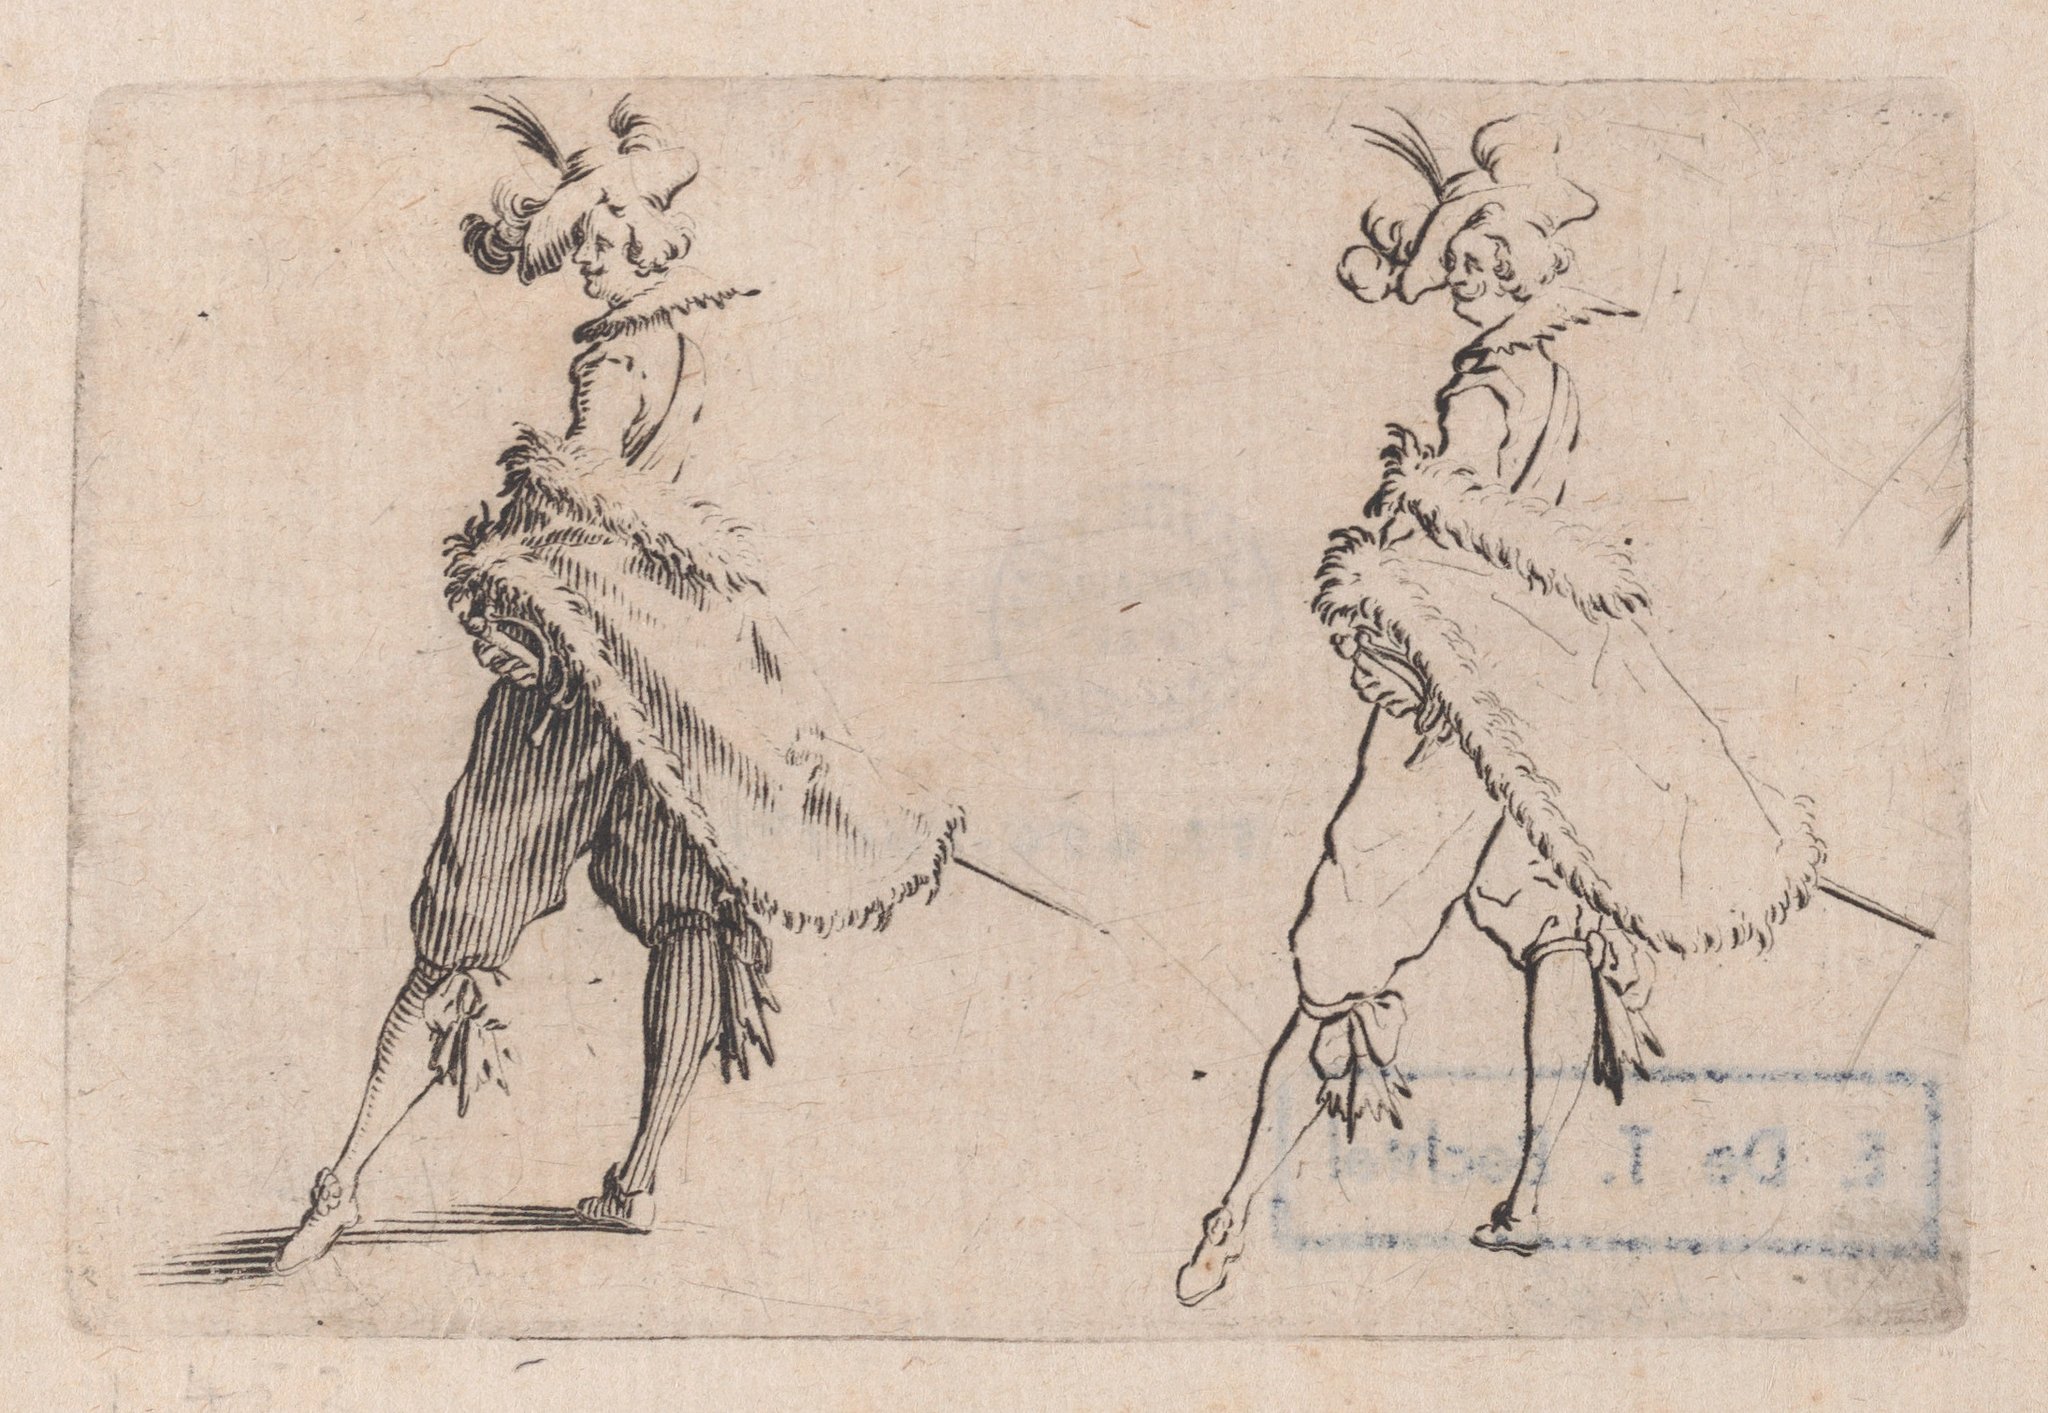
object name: print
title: Le Gentilhomme au Manteau Posé sur la Hanche (The Gentleman with his Mantle on his Hip), from "Les Caprices" Series B, The Nancy Set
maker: jacques callot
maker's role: artist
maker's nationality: french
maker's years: 1592-1635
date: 1617-1620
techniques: etching